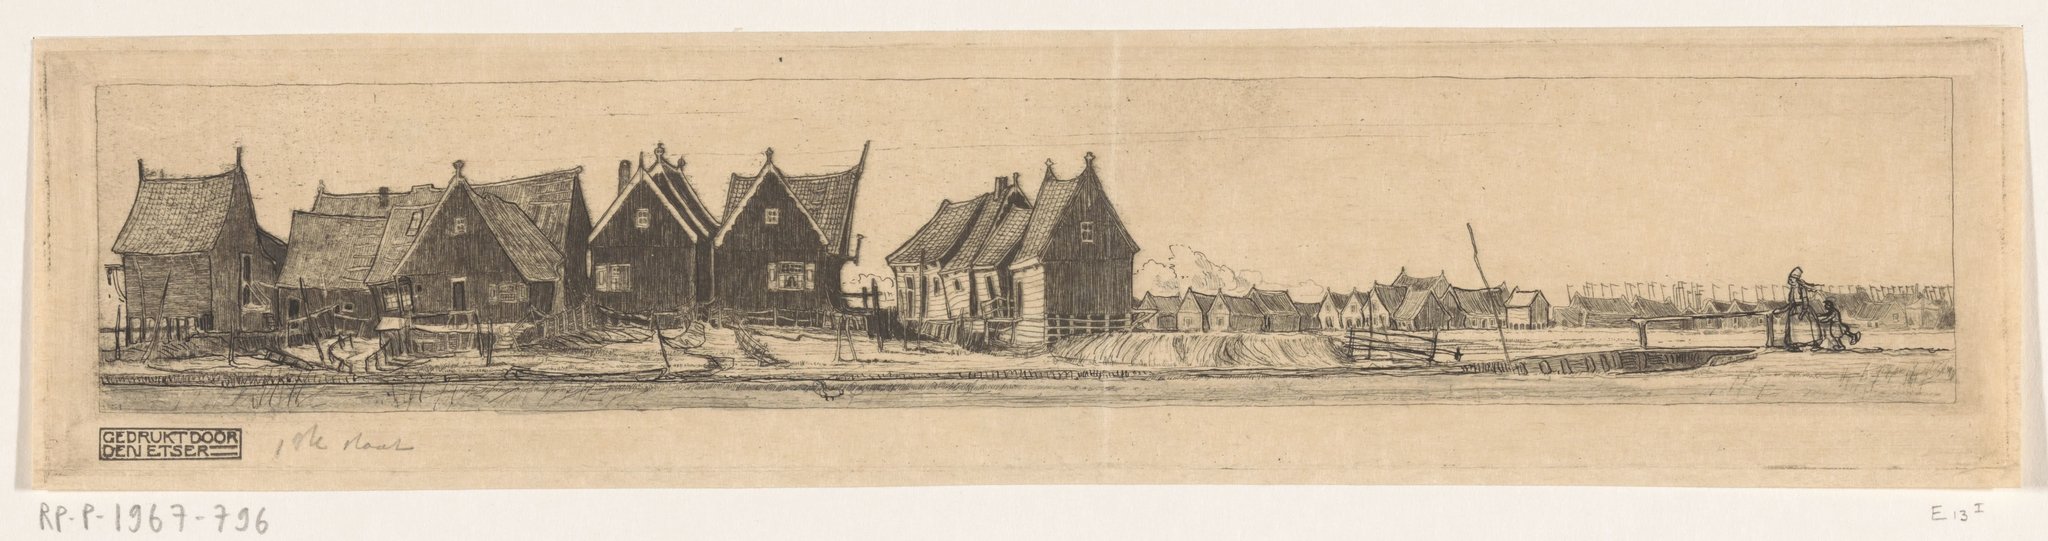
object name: print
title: Op het eiland Marken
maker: wijnand otto jan nieuwenkamp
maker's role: draughtsman, print maker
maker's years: 1874-1950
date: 1896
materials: ink, paper, pencil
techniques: etching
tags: village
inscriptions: collector's mark: Lugt 2760, collector's mark: Lugt 2228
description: De Wittewerf op het eiland Marken. Op de achtergrond de Havenbuurt.